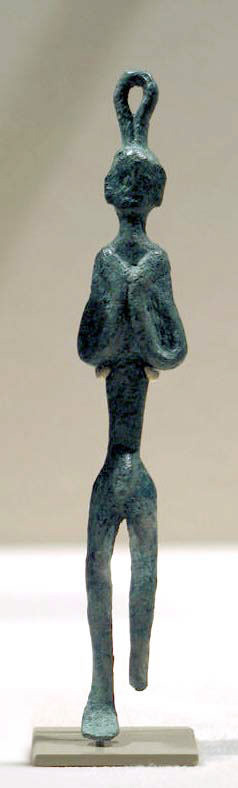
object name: lime spatula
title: Anthropomorphic Lime Spatula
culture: indonesian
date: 500 BCE-300 CE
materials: bronze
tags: human figures